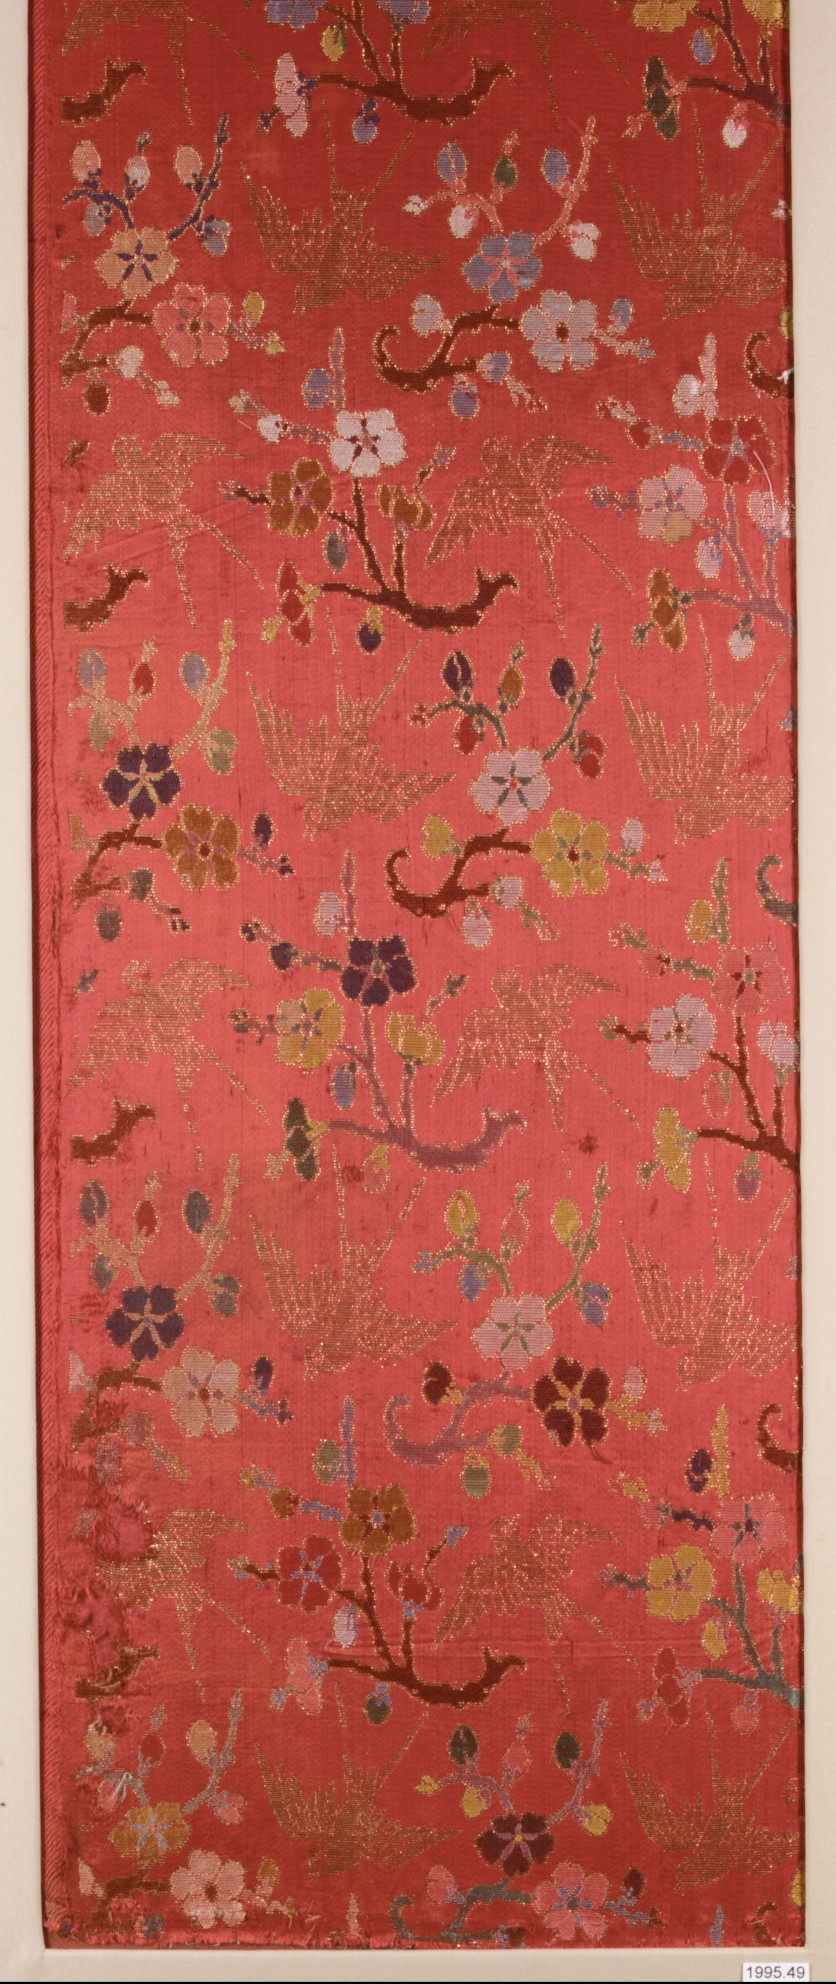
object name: panel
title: Woven Panel with Swallows and Prunus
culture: chinese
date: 1601-1700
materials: metal thread, silk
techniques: brocade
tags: birds,flowers